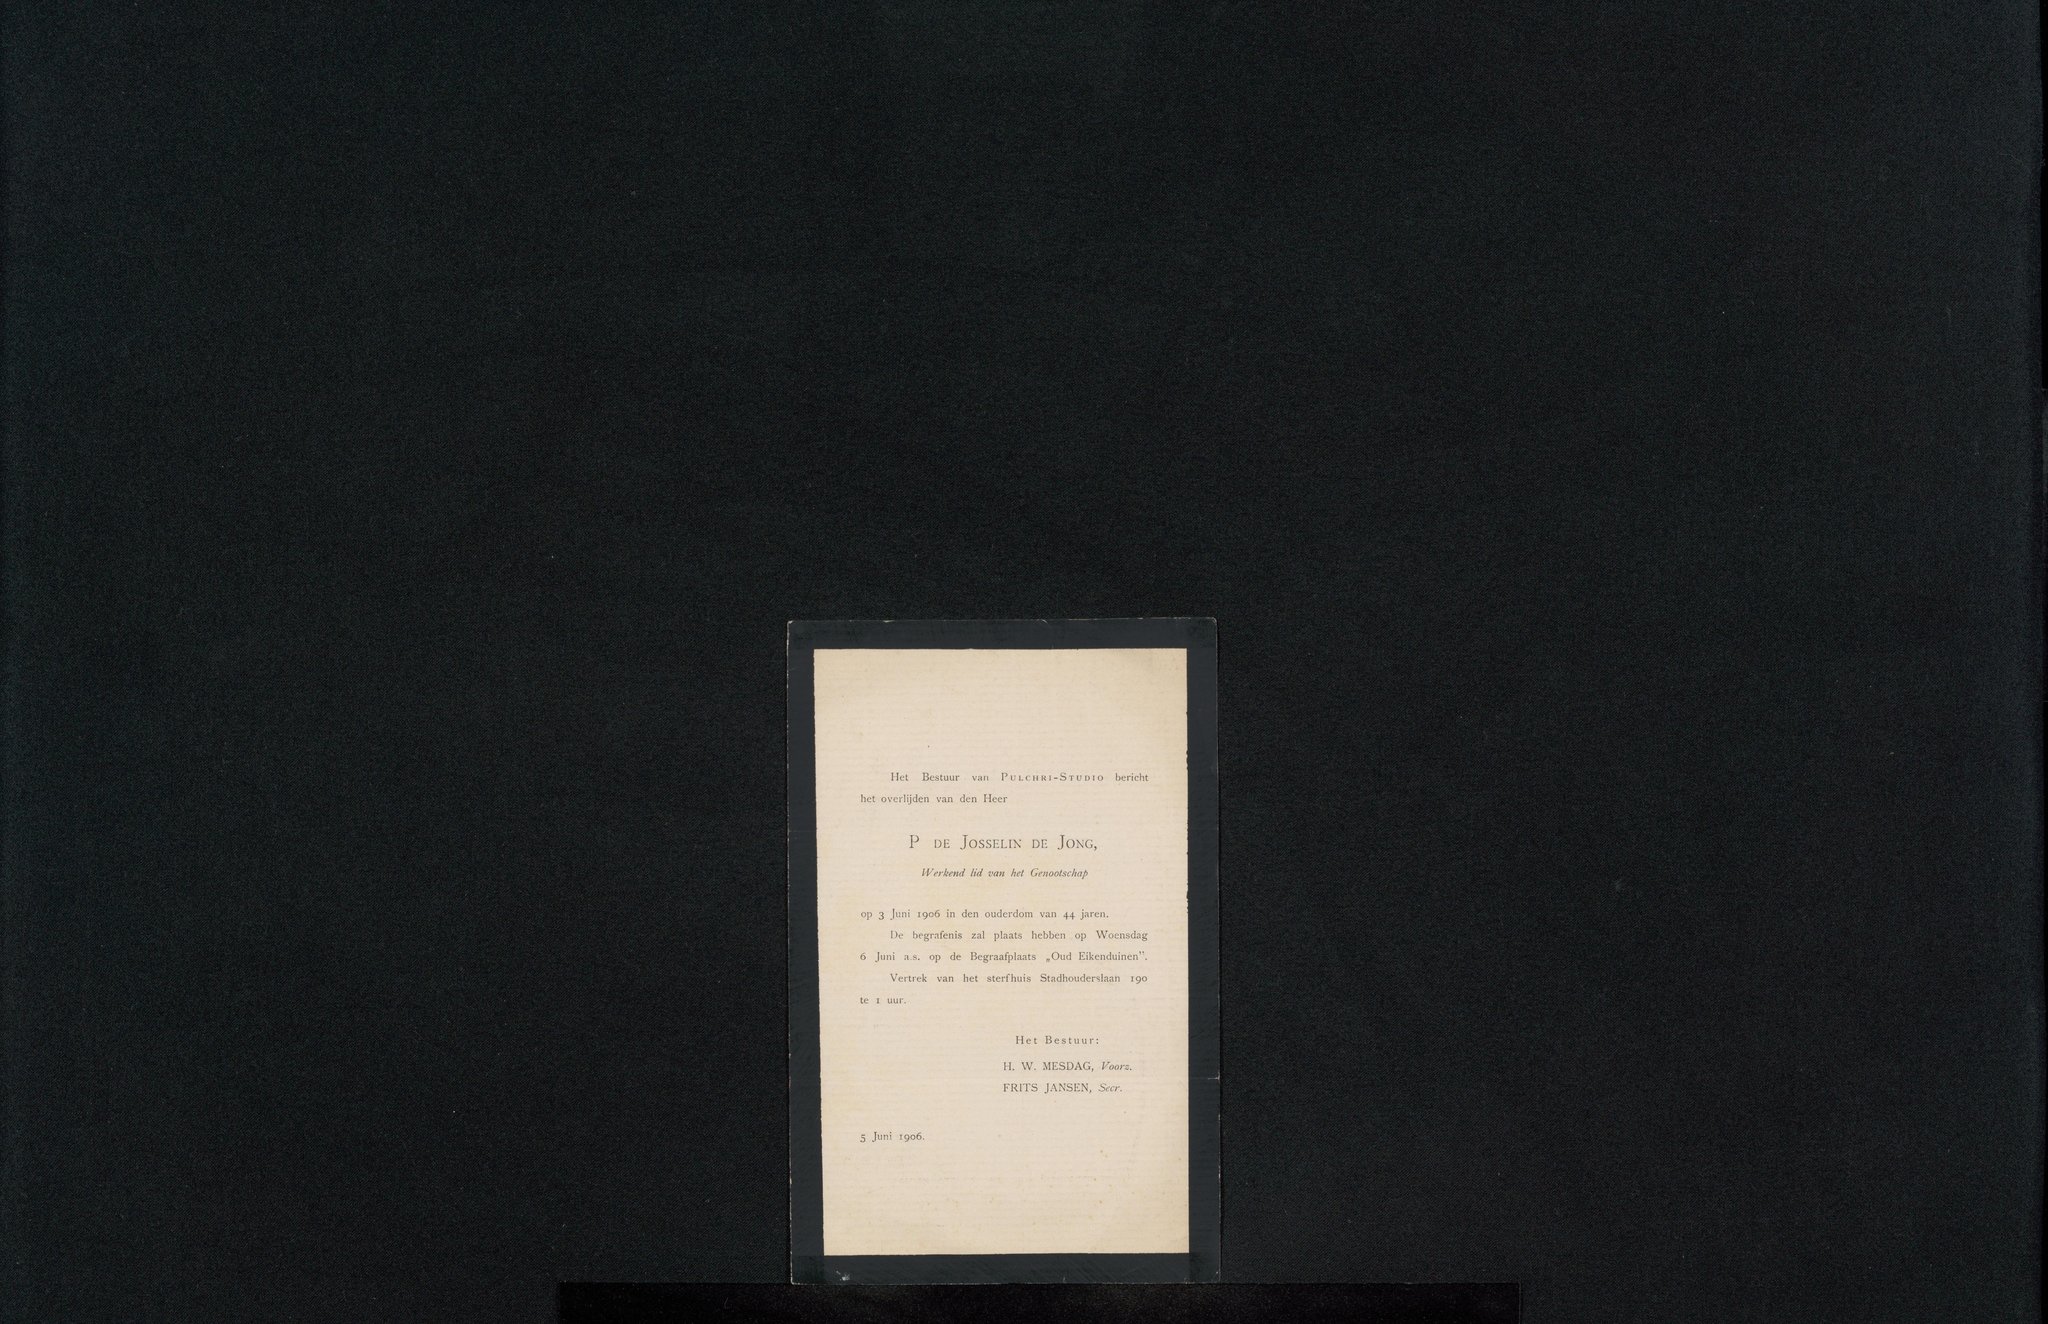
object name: overlijdensbericht, overlijdensadvertentie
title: Overlijdensbericht aan Philip Zilcken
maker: Anonymous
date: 1906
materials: paper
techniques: printing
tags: the hague, painter, print maker, draughtsman, hendrik willem mesdag, pieter de josselin de jong, voorburg, frits jansen, philip zilcken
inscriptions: collector's mark: ‘RPK’